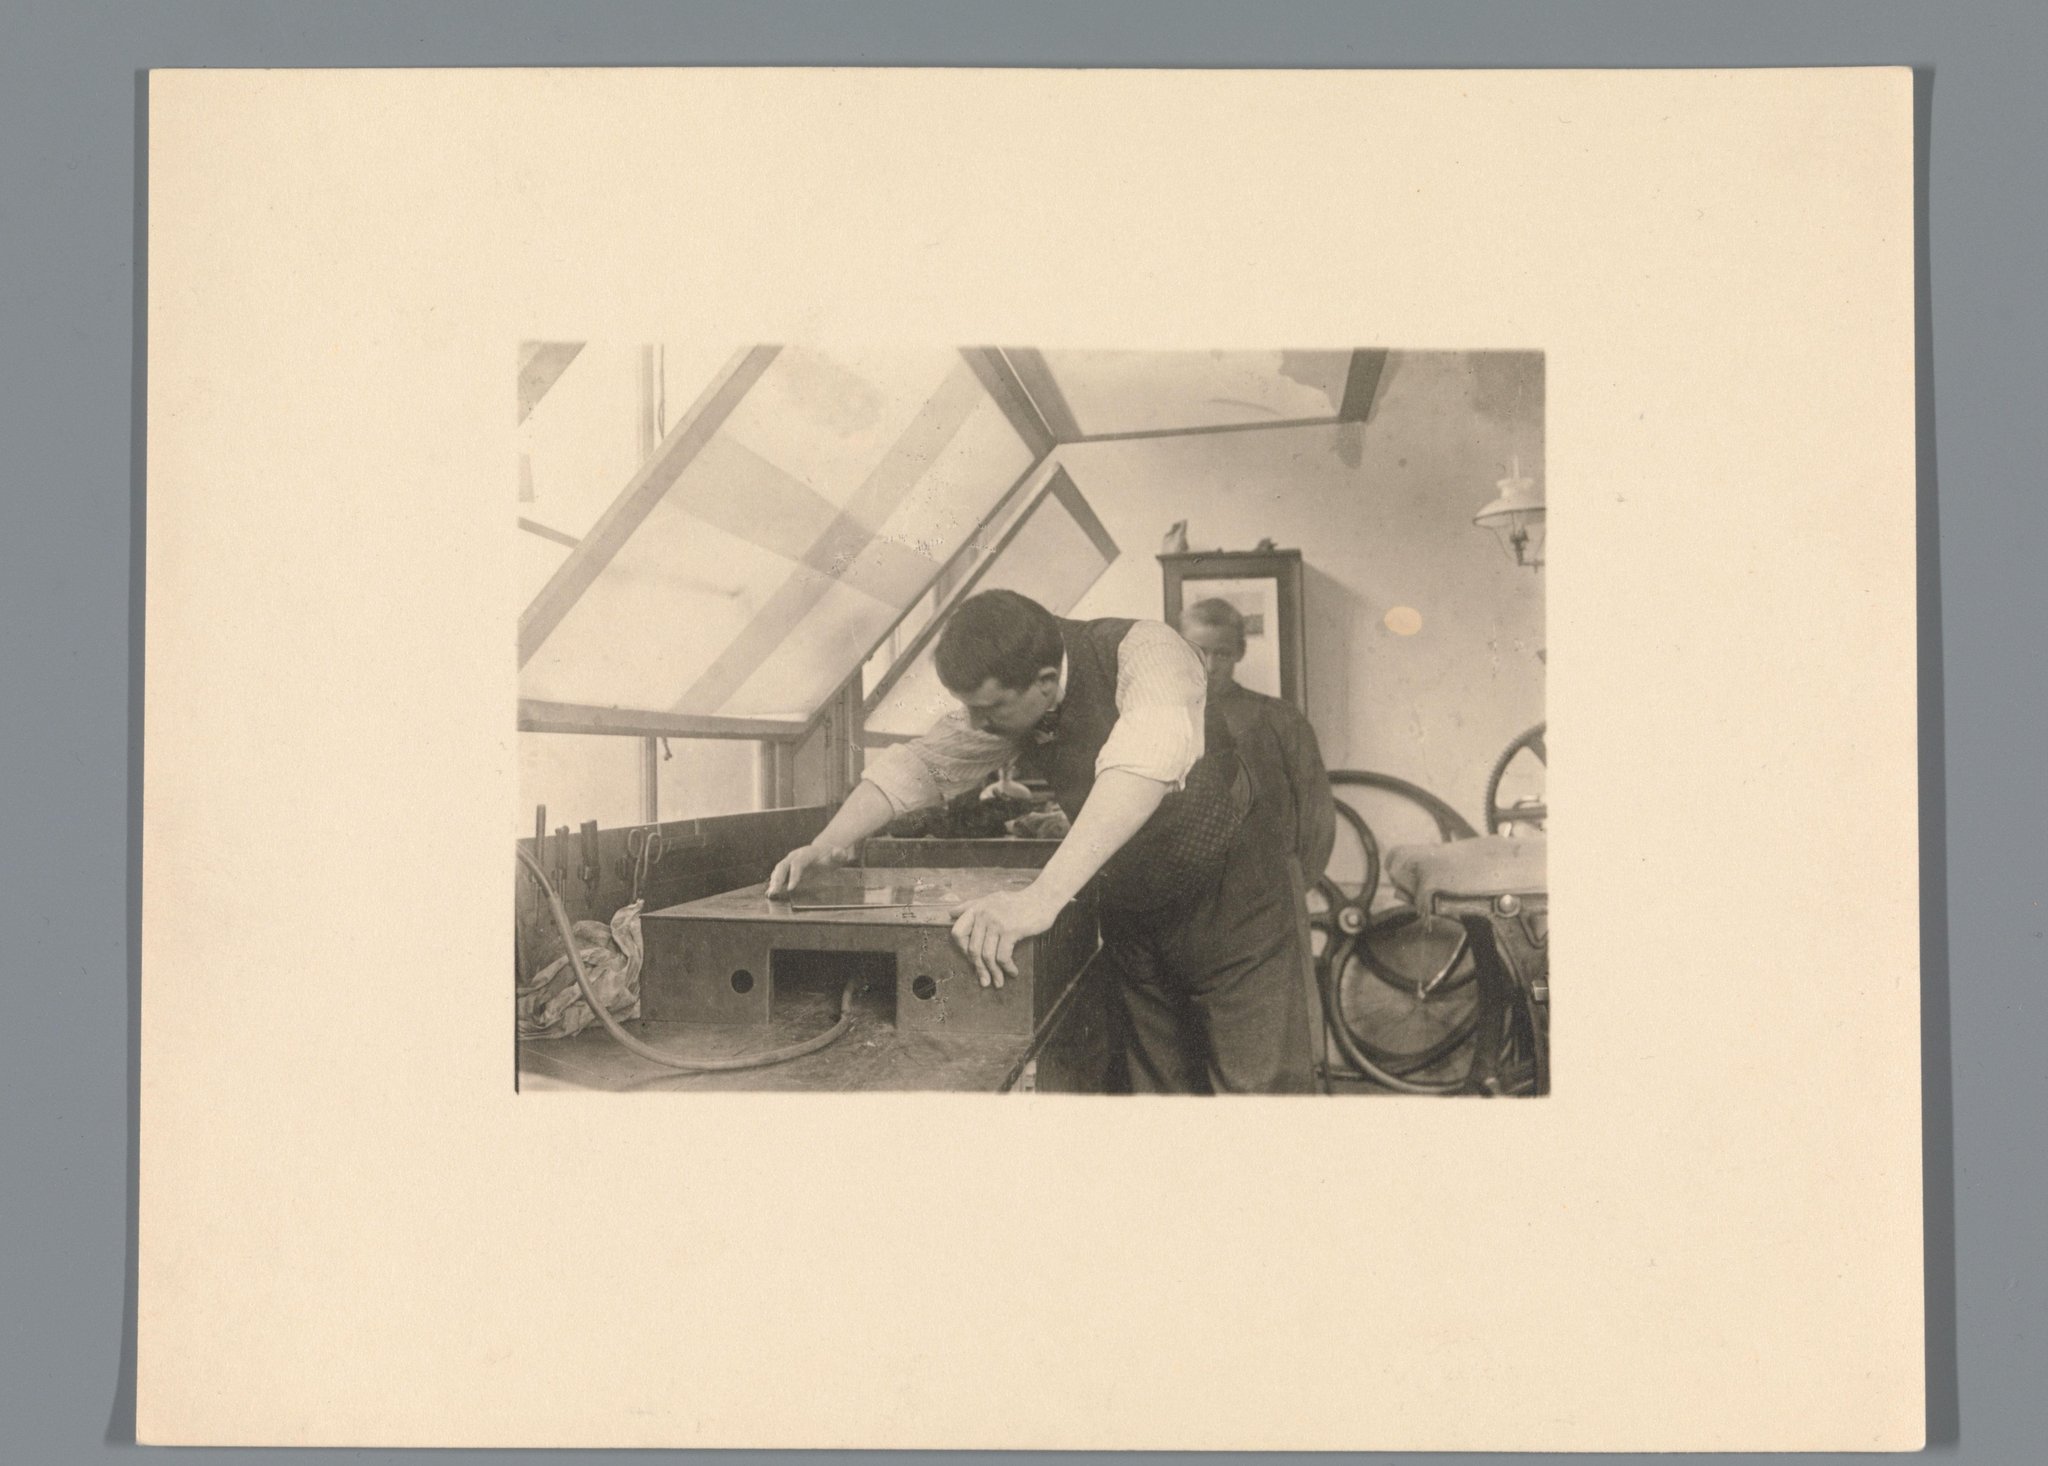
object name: photograph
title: Reproductie naar een foto van Willem Witsen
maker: Anonymous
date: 1860-1915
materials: paper, photographic support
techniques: gelatin silver print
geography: netherlands